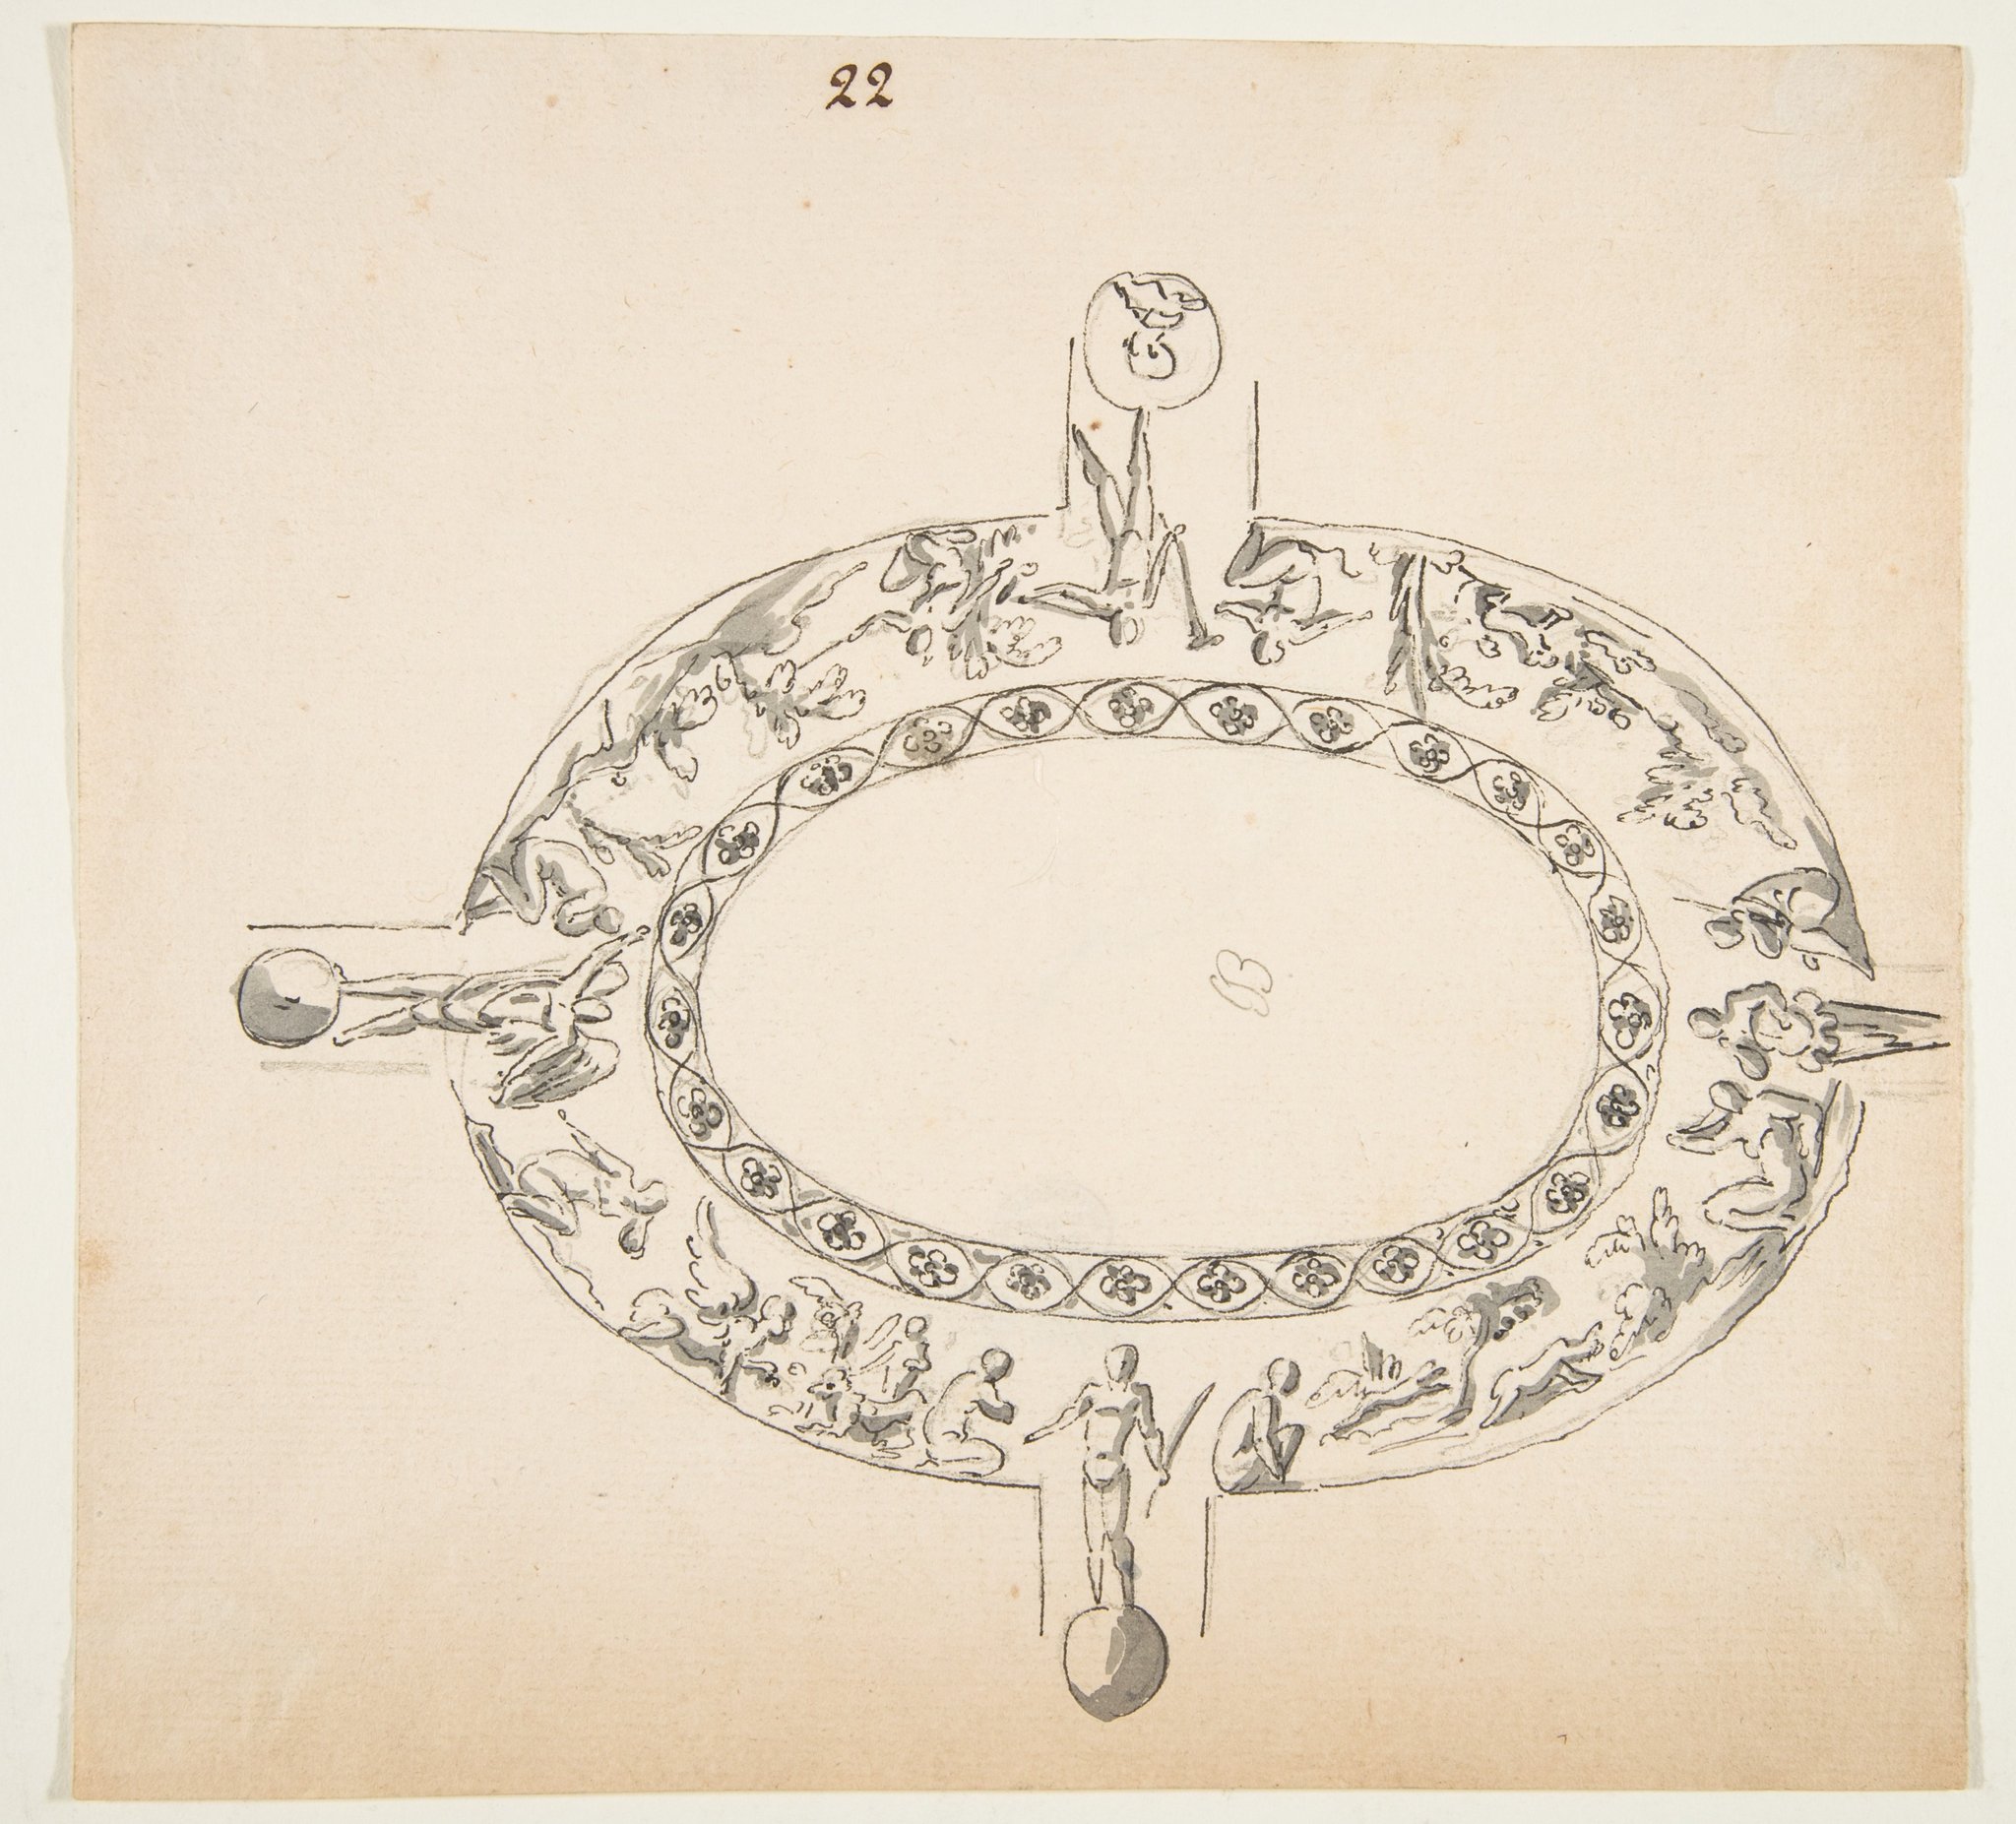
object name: drawing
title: Drawing After an Architectural Fragment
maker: anonymous, french, 19th century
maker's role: artist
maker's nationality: french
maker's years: 1800-1900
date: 1801-1900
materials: graphite, ink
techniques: pen, wash